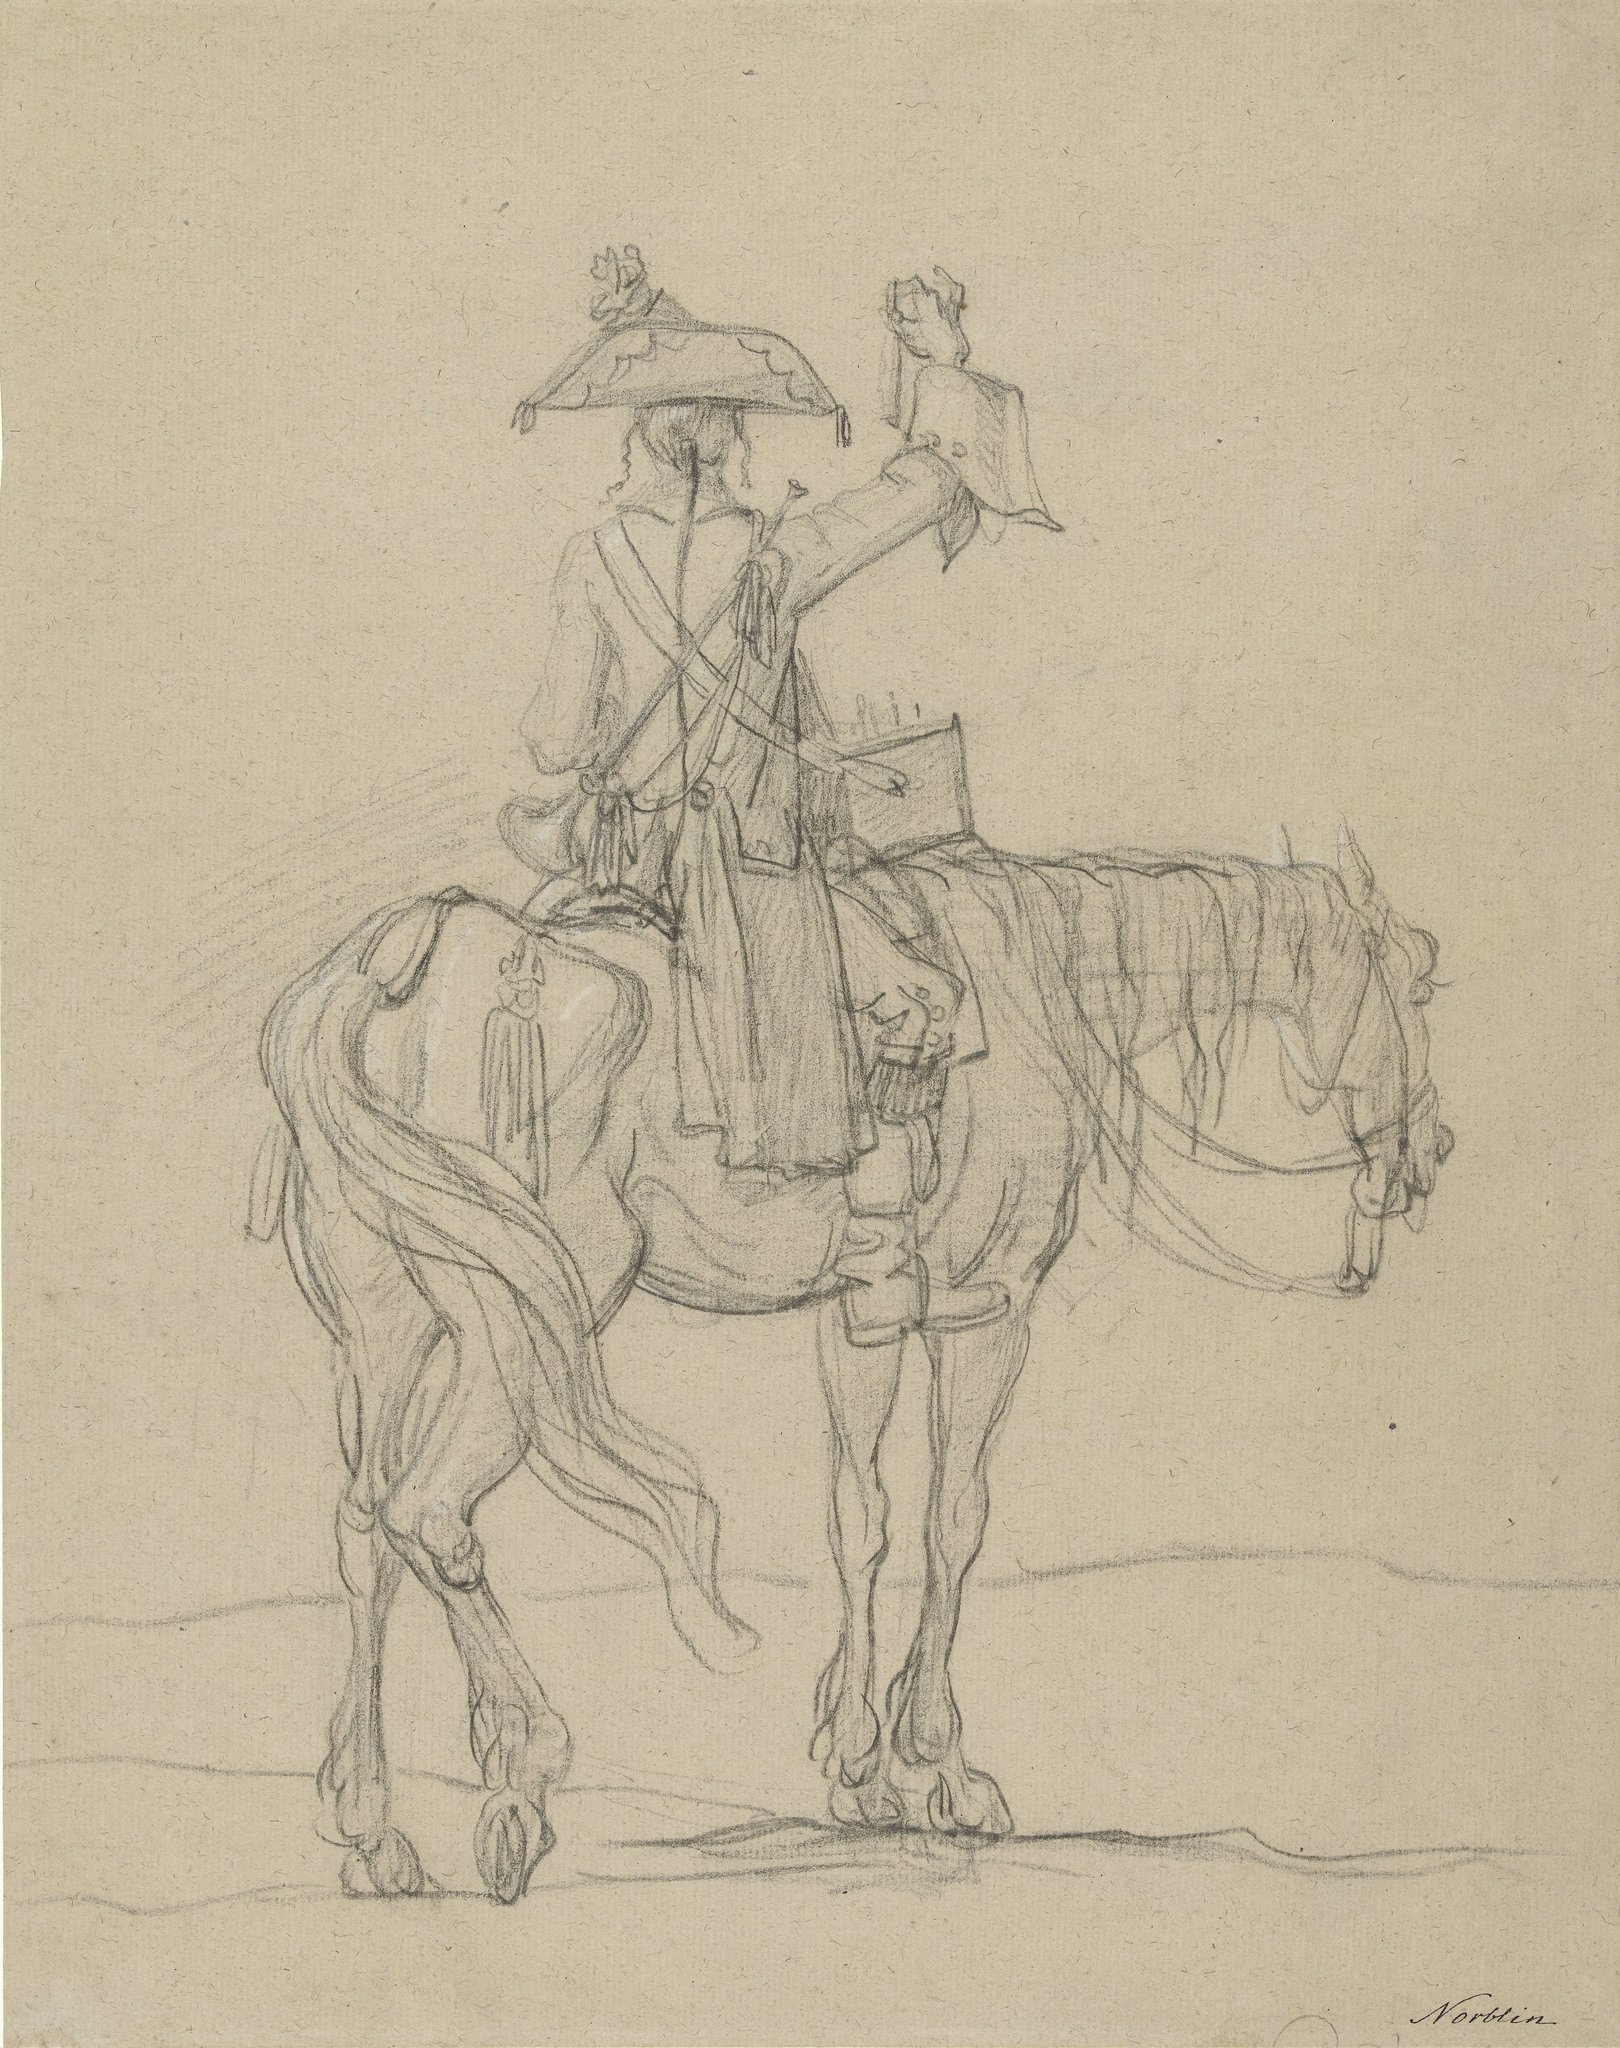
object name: drawing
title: Koopman te paard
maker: jean pierre norblin de la gourdaine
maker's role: print maker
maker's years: 1745-1830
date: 1772-1830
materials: chalk, paper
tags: riding a horse, ass, or mule; rider, horseman, wandering or travelling merchant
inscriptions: annotation, verso, lower right, pencil: ‘L.B. f(?)’, annotation, recto, lower right, pen and black ink: ‘Norblin’